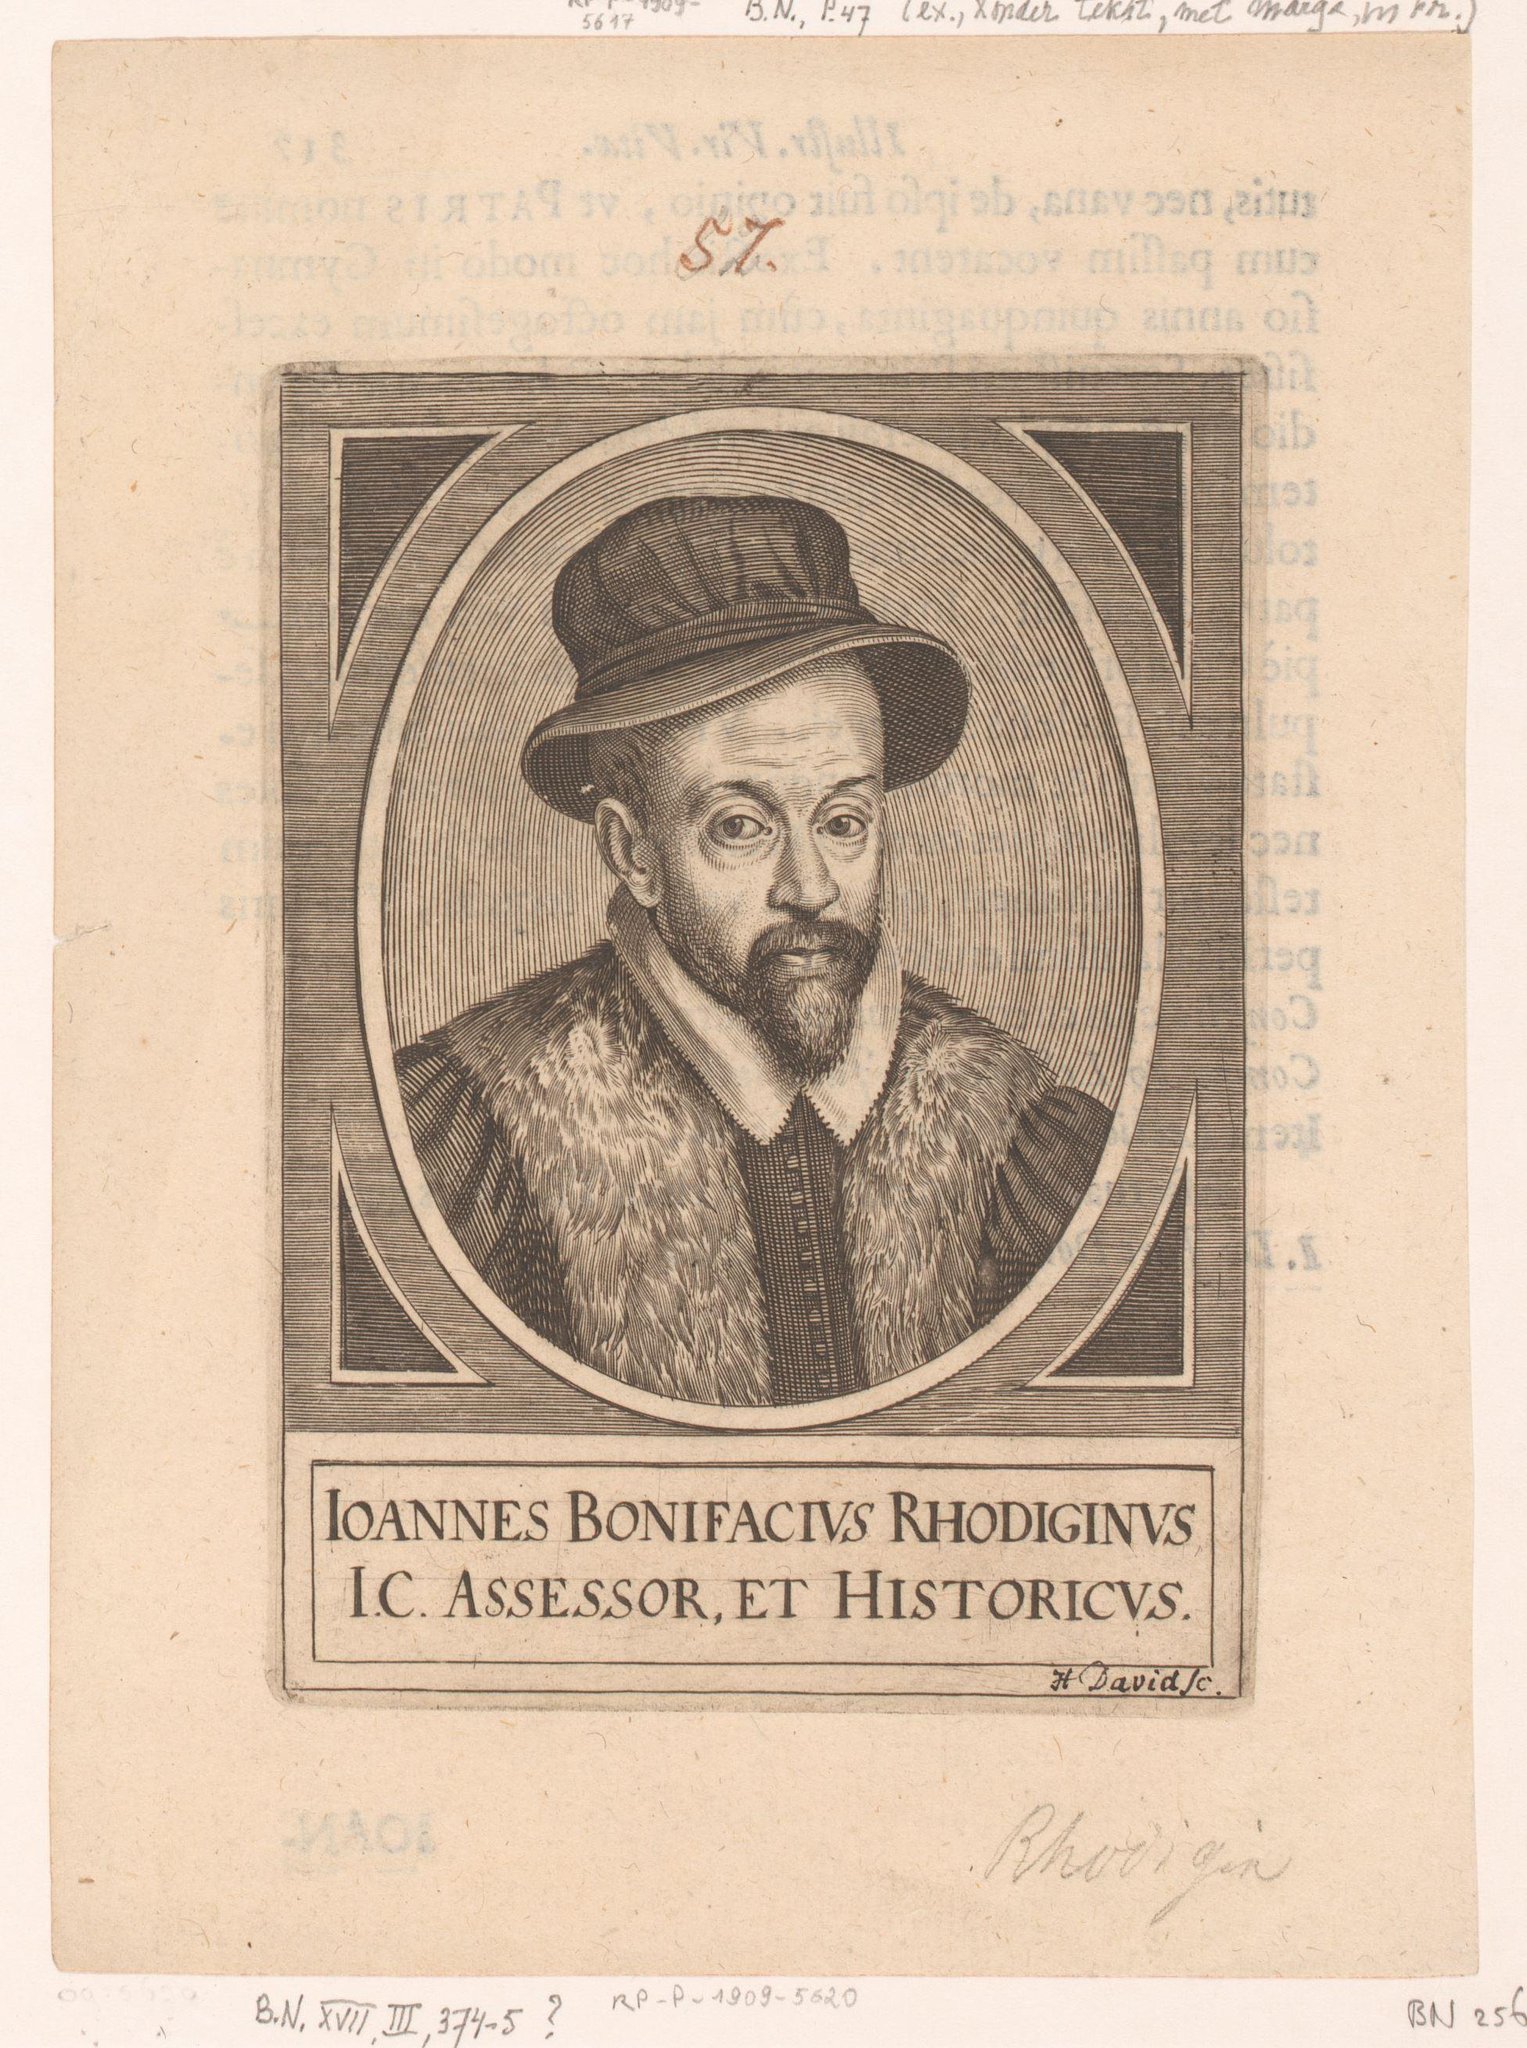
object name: book illustration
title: Joannes Bonifacius Rhodiginus I.C. Assessor, et Historicus.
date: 1630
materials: paper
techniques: engraving, letterpress printing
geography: france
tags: historical persons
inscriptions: collector's mark: Lugt 2228, inscription: ‘S.T.’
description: Mogelijk prent uit: Prent uit: Tomasini, Jacopo Filippo. Jacobi Philippi Tomasini Patavini Illustrium Virorum Elogia Iconibus Exornata (...). Padua: Donato Pasquardi, 1630.